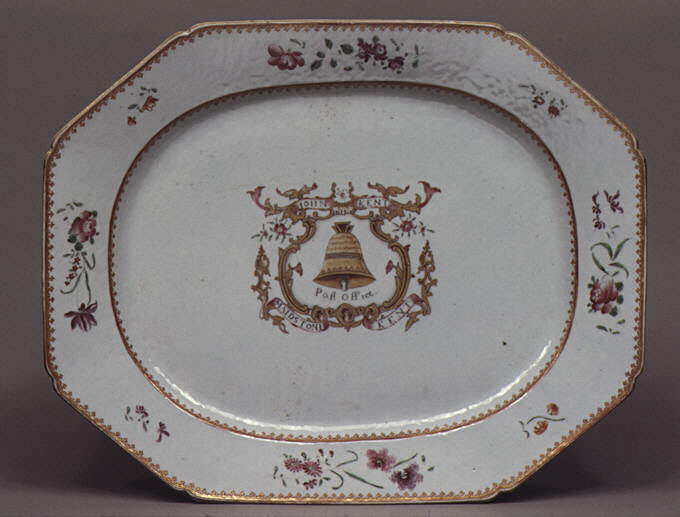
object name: platter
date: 1750-1760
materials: hard paste porcelain